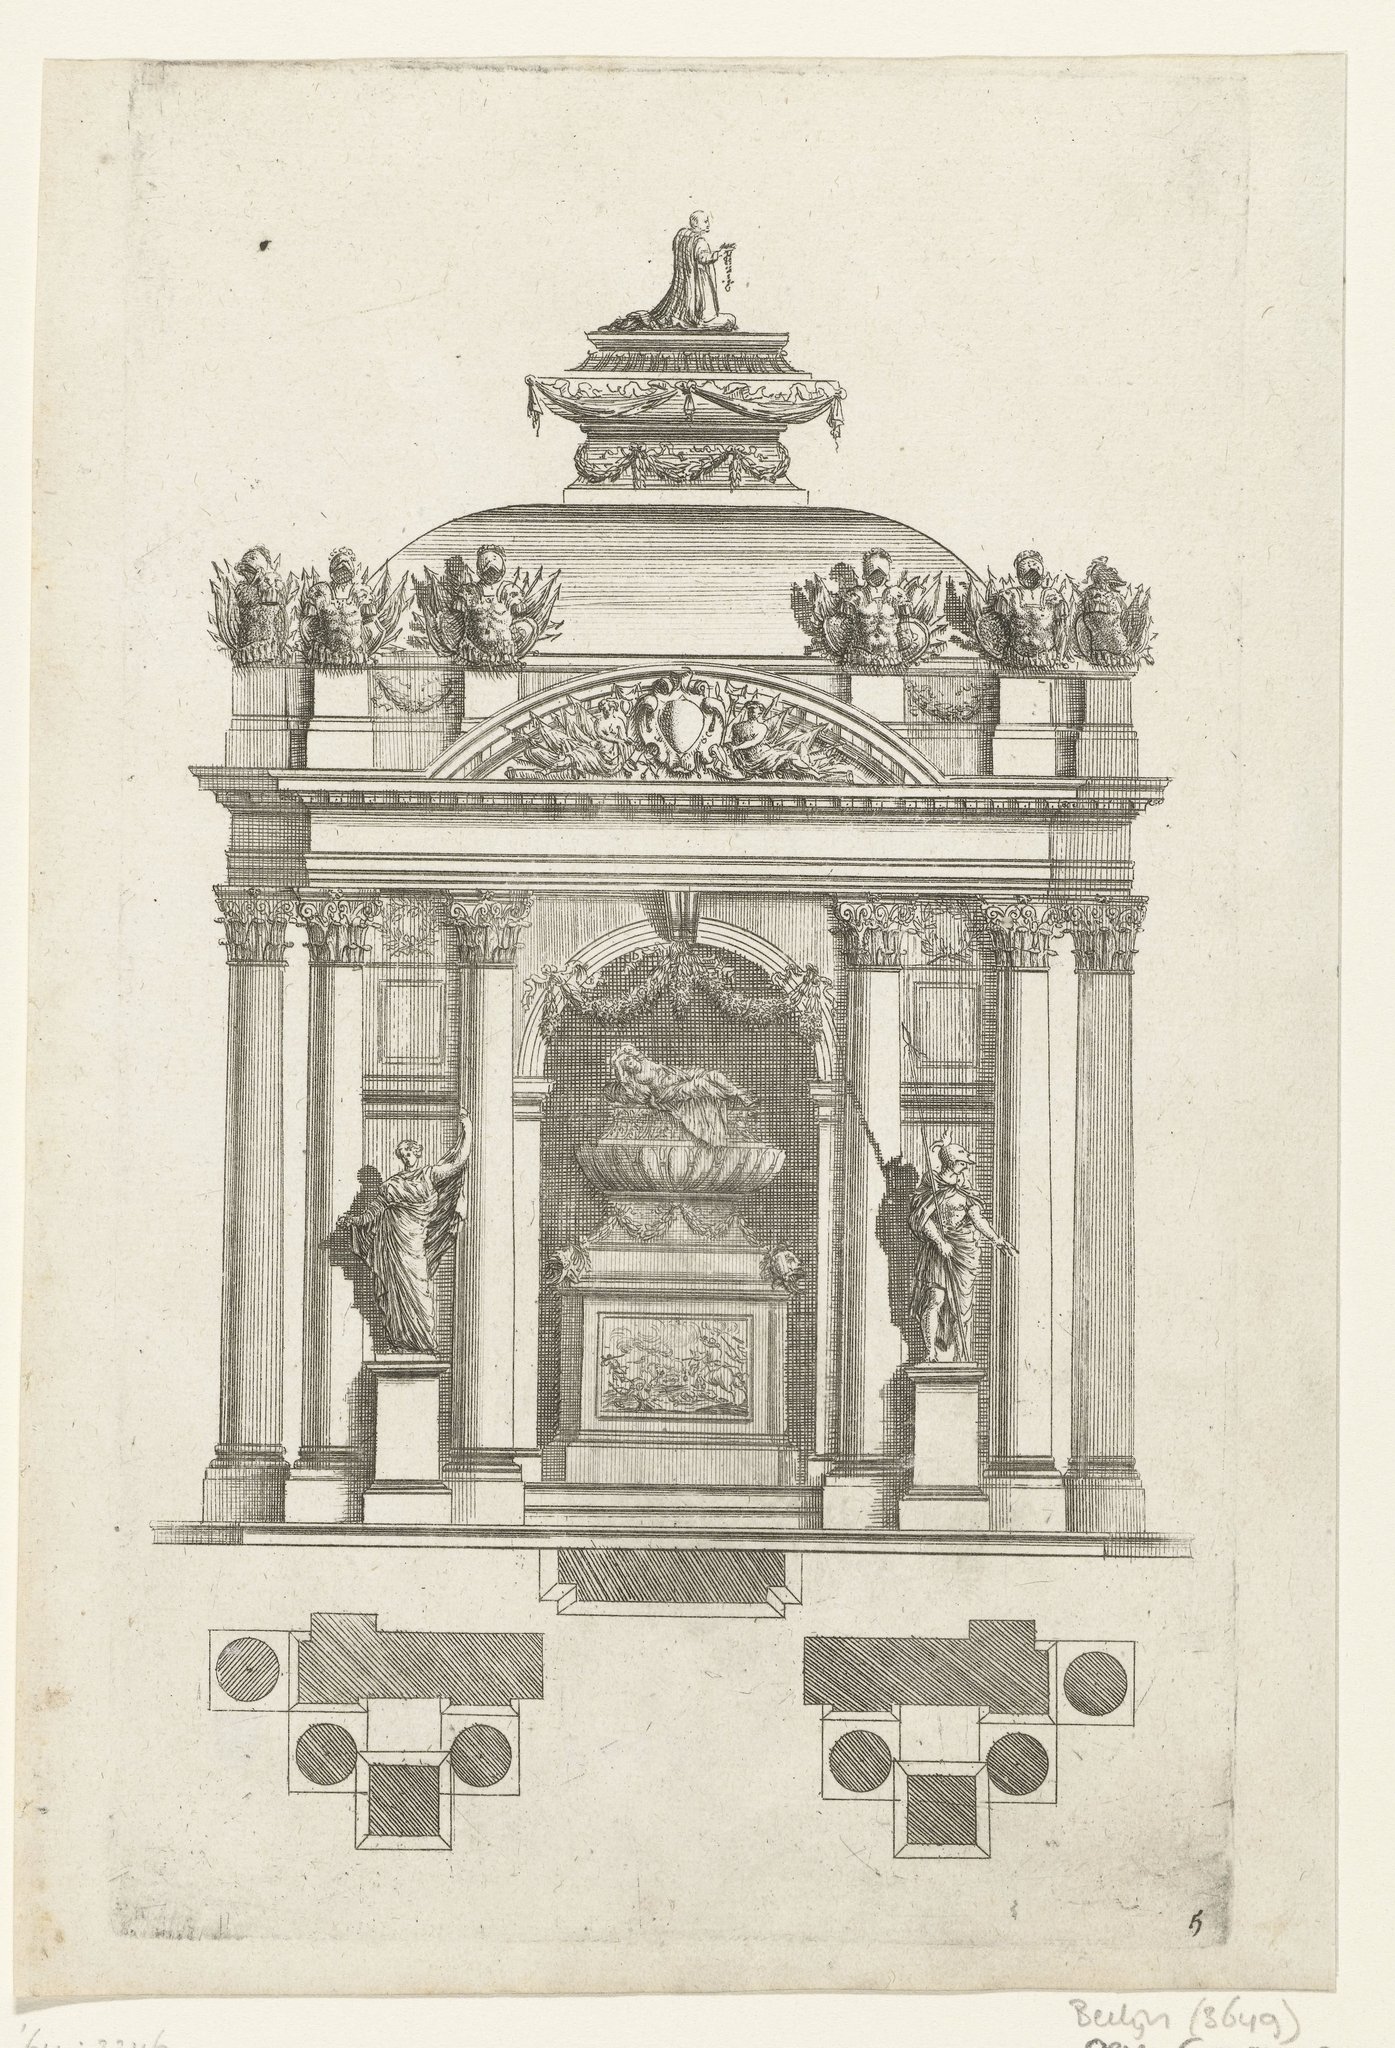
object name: print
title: Tombeaux ou Mausolées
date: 1629-1716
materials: paper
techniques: engraving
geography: paris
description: In het midden staat een triomfboog. Uit eerste editie.